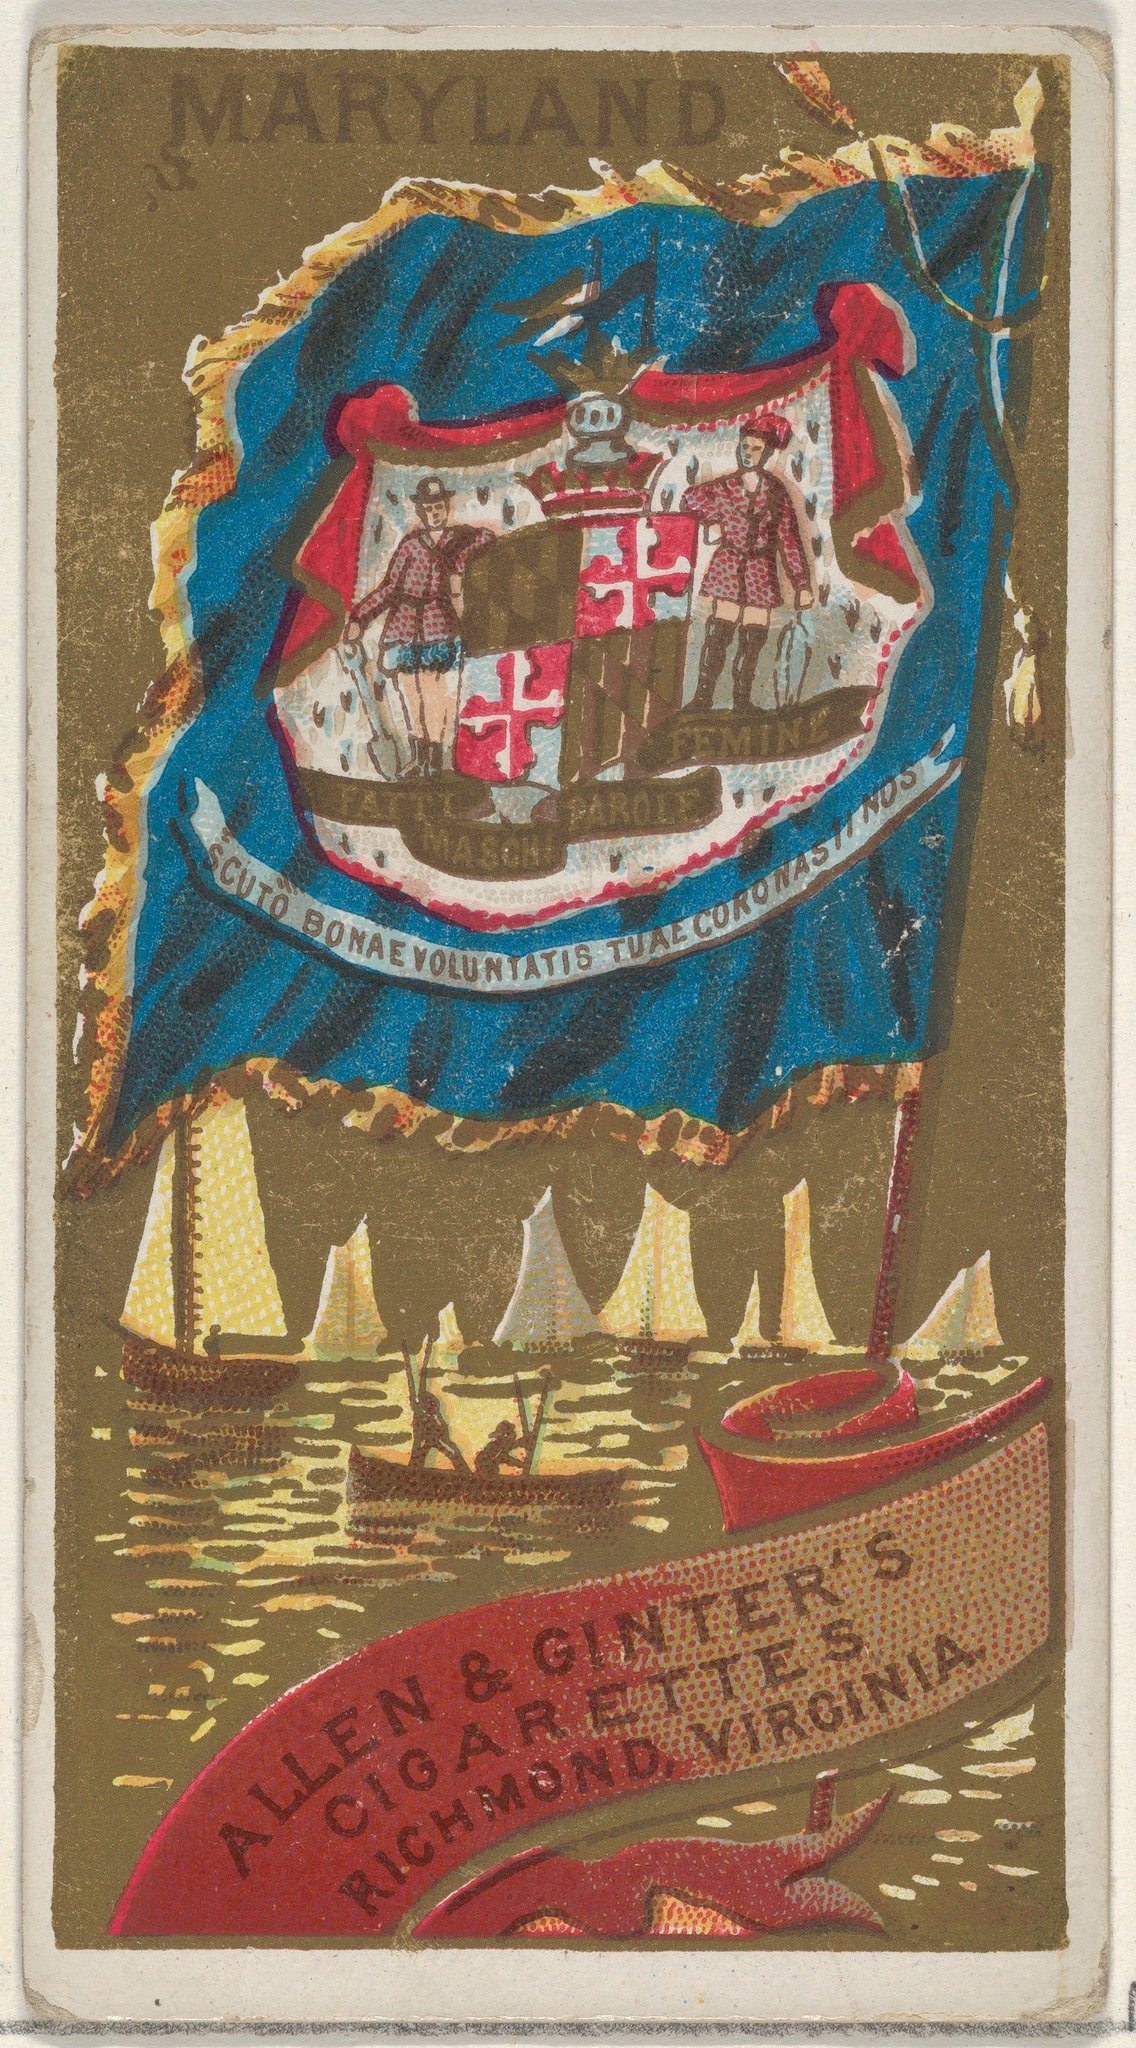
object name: print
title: Maryland, from Flags of the States and Territories (N11) for Allen & Ginter Cigarettes Brands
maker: allen & ginter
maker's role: publisher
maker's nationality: american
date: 1888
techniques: color lithograph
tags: flags